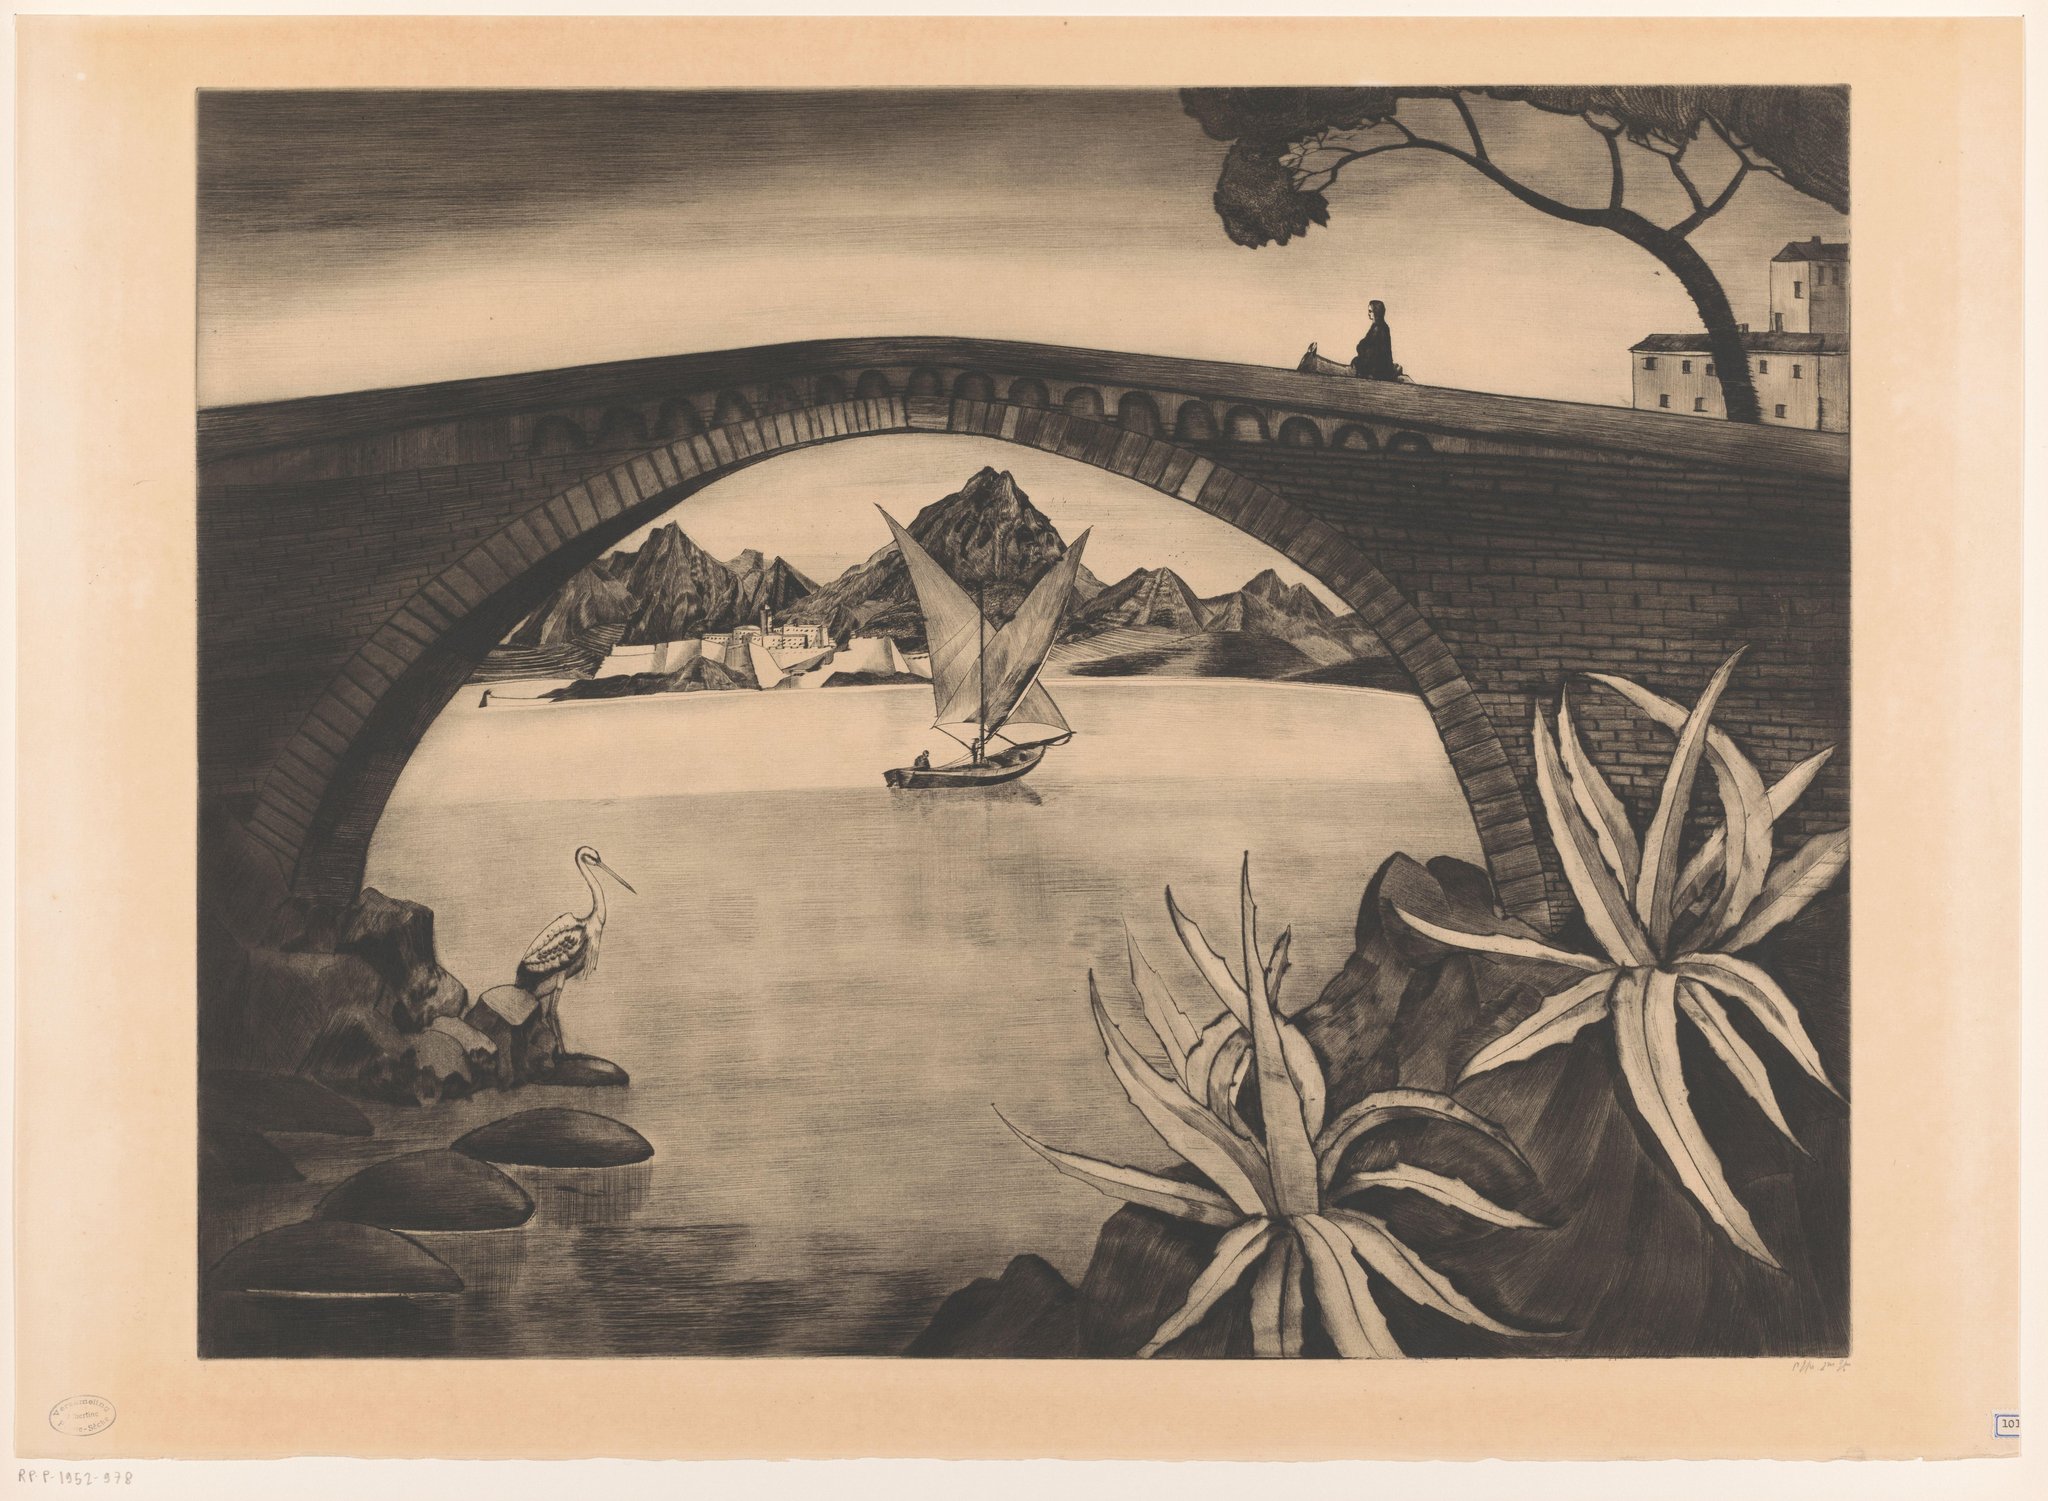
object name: print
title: Boogbrug op Corsica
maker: lodewijk schelfhout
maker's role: draughtsman, print maker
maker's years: 1881-1943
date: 1922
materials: paper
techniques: drypoint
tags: riding a horse, ass, or mule; rider, horseman, shore-birds and wading-birds: heron, landscapes with waters, waterscapes, seascapes (in the temperate zone), bridge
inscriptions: collector's mark: Lugt 2760, collector's mark: Lugt 5i, collector's mark: Lugt 2228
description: Er rijdt een vrouw op een ezel over de brug. Bij de voet van de brug bevinden zich planten en een reiger. Onder de brug door is er zicht op een zeilschip, een ommuurde nederzetting en bergen.